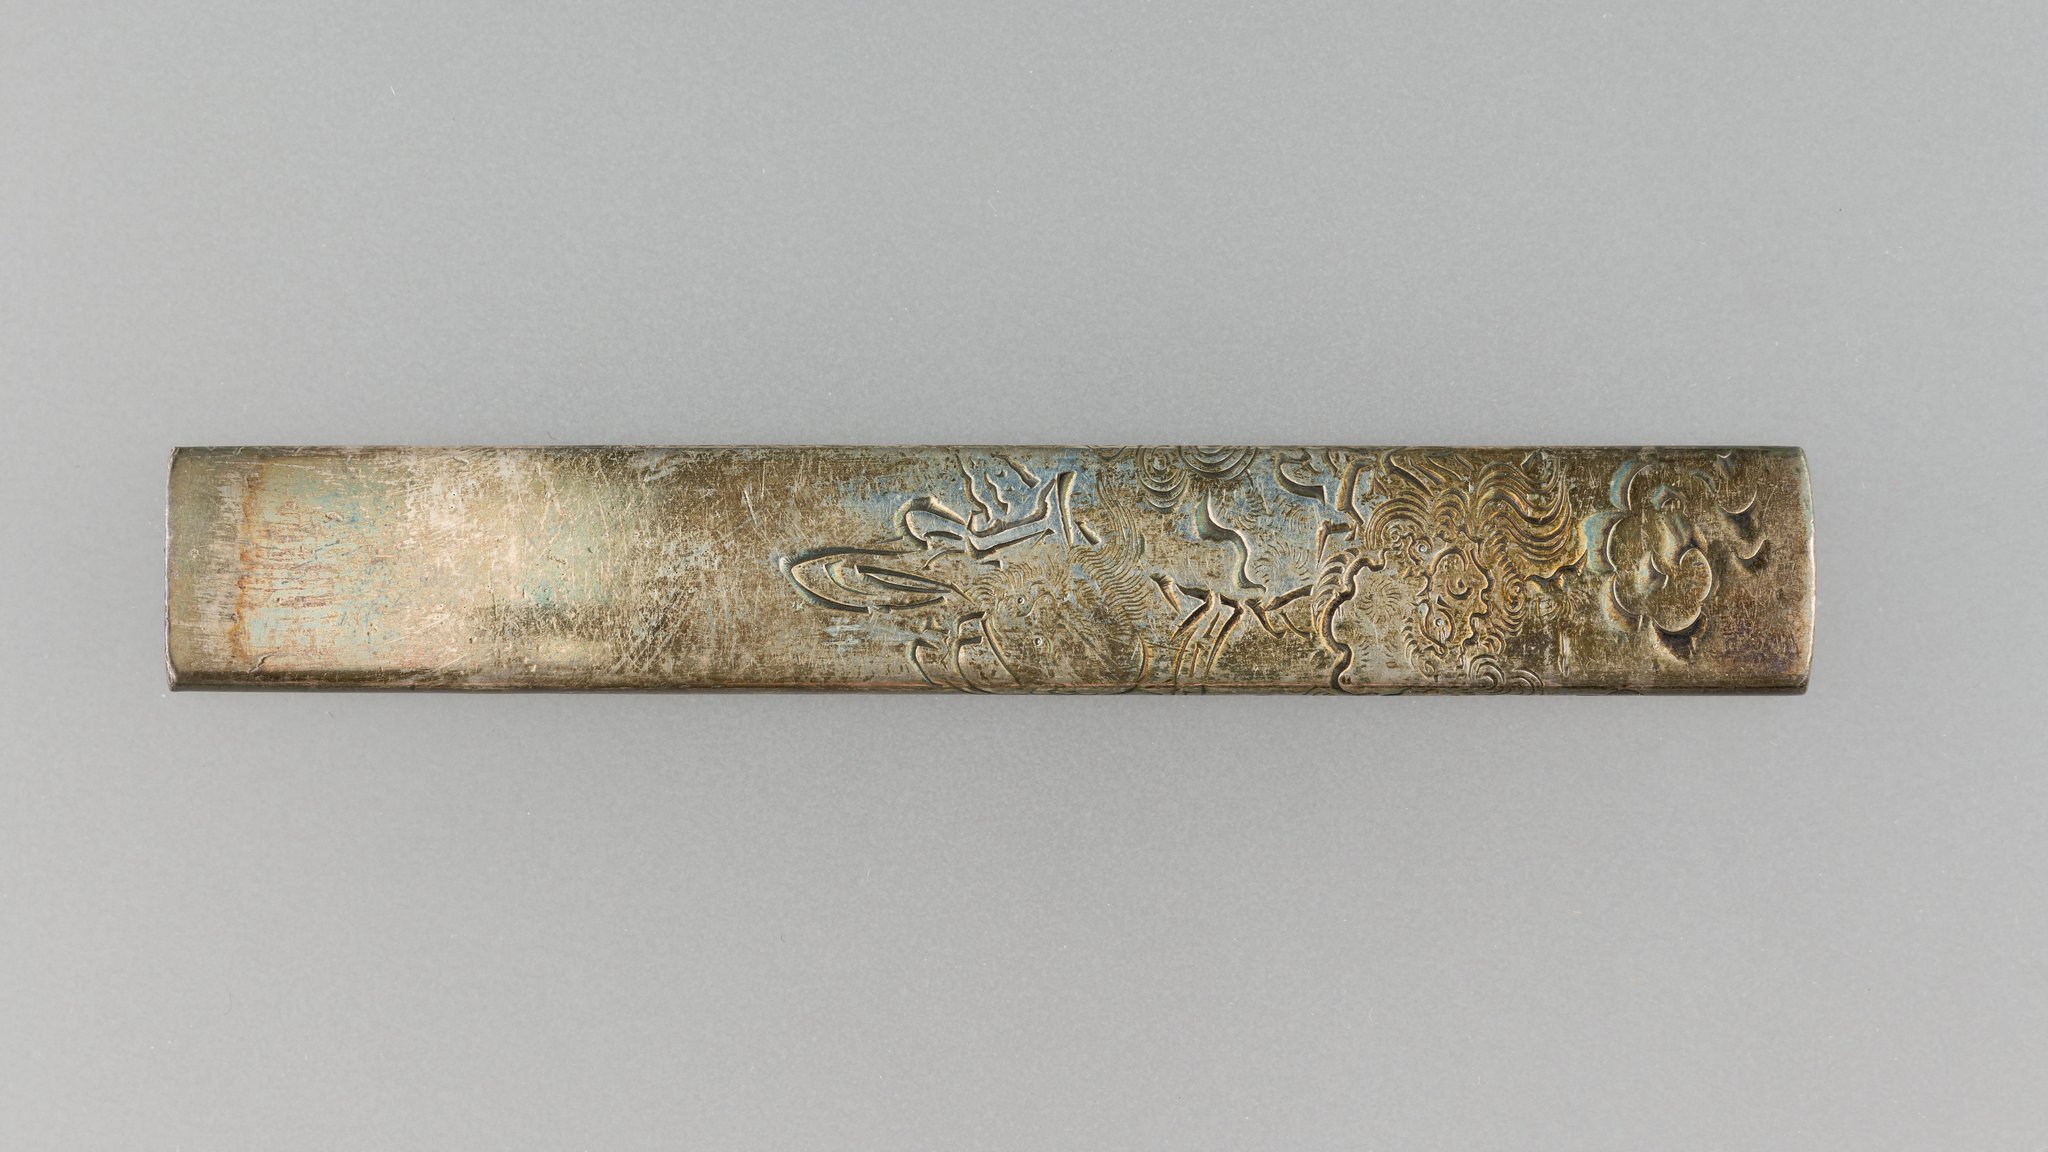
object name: knife handle kozuka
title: Knife Handle (Kozuka)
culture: japanese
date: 1634-1766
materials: silver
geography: japan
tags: men